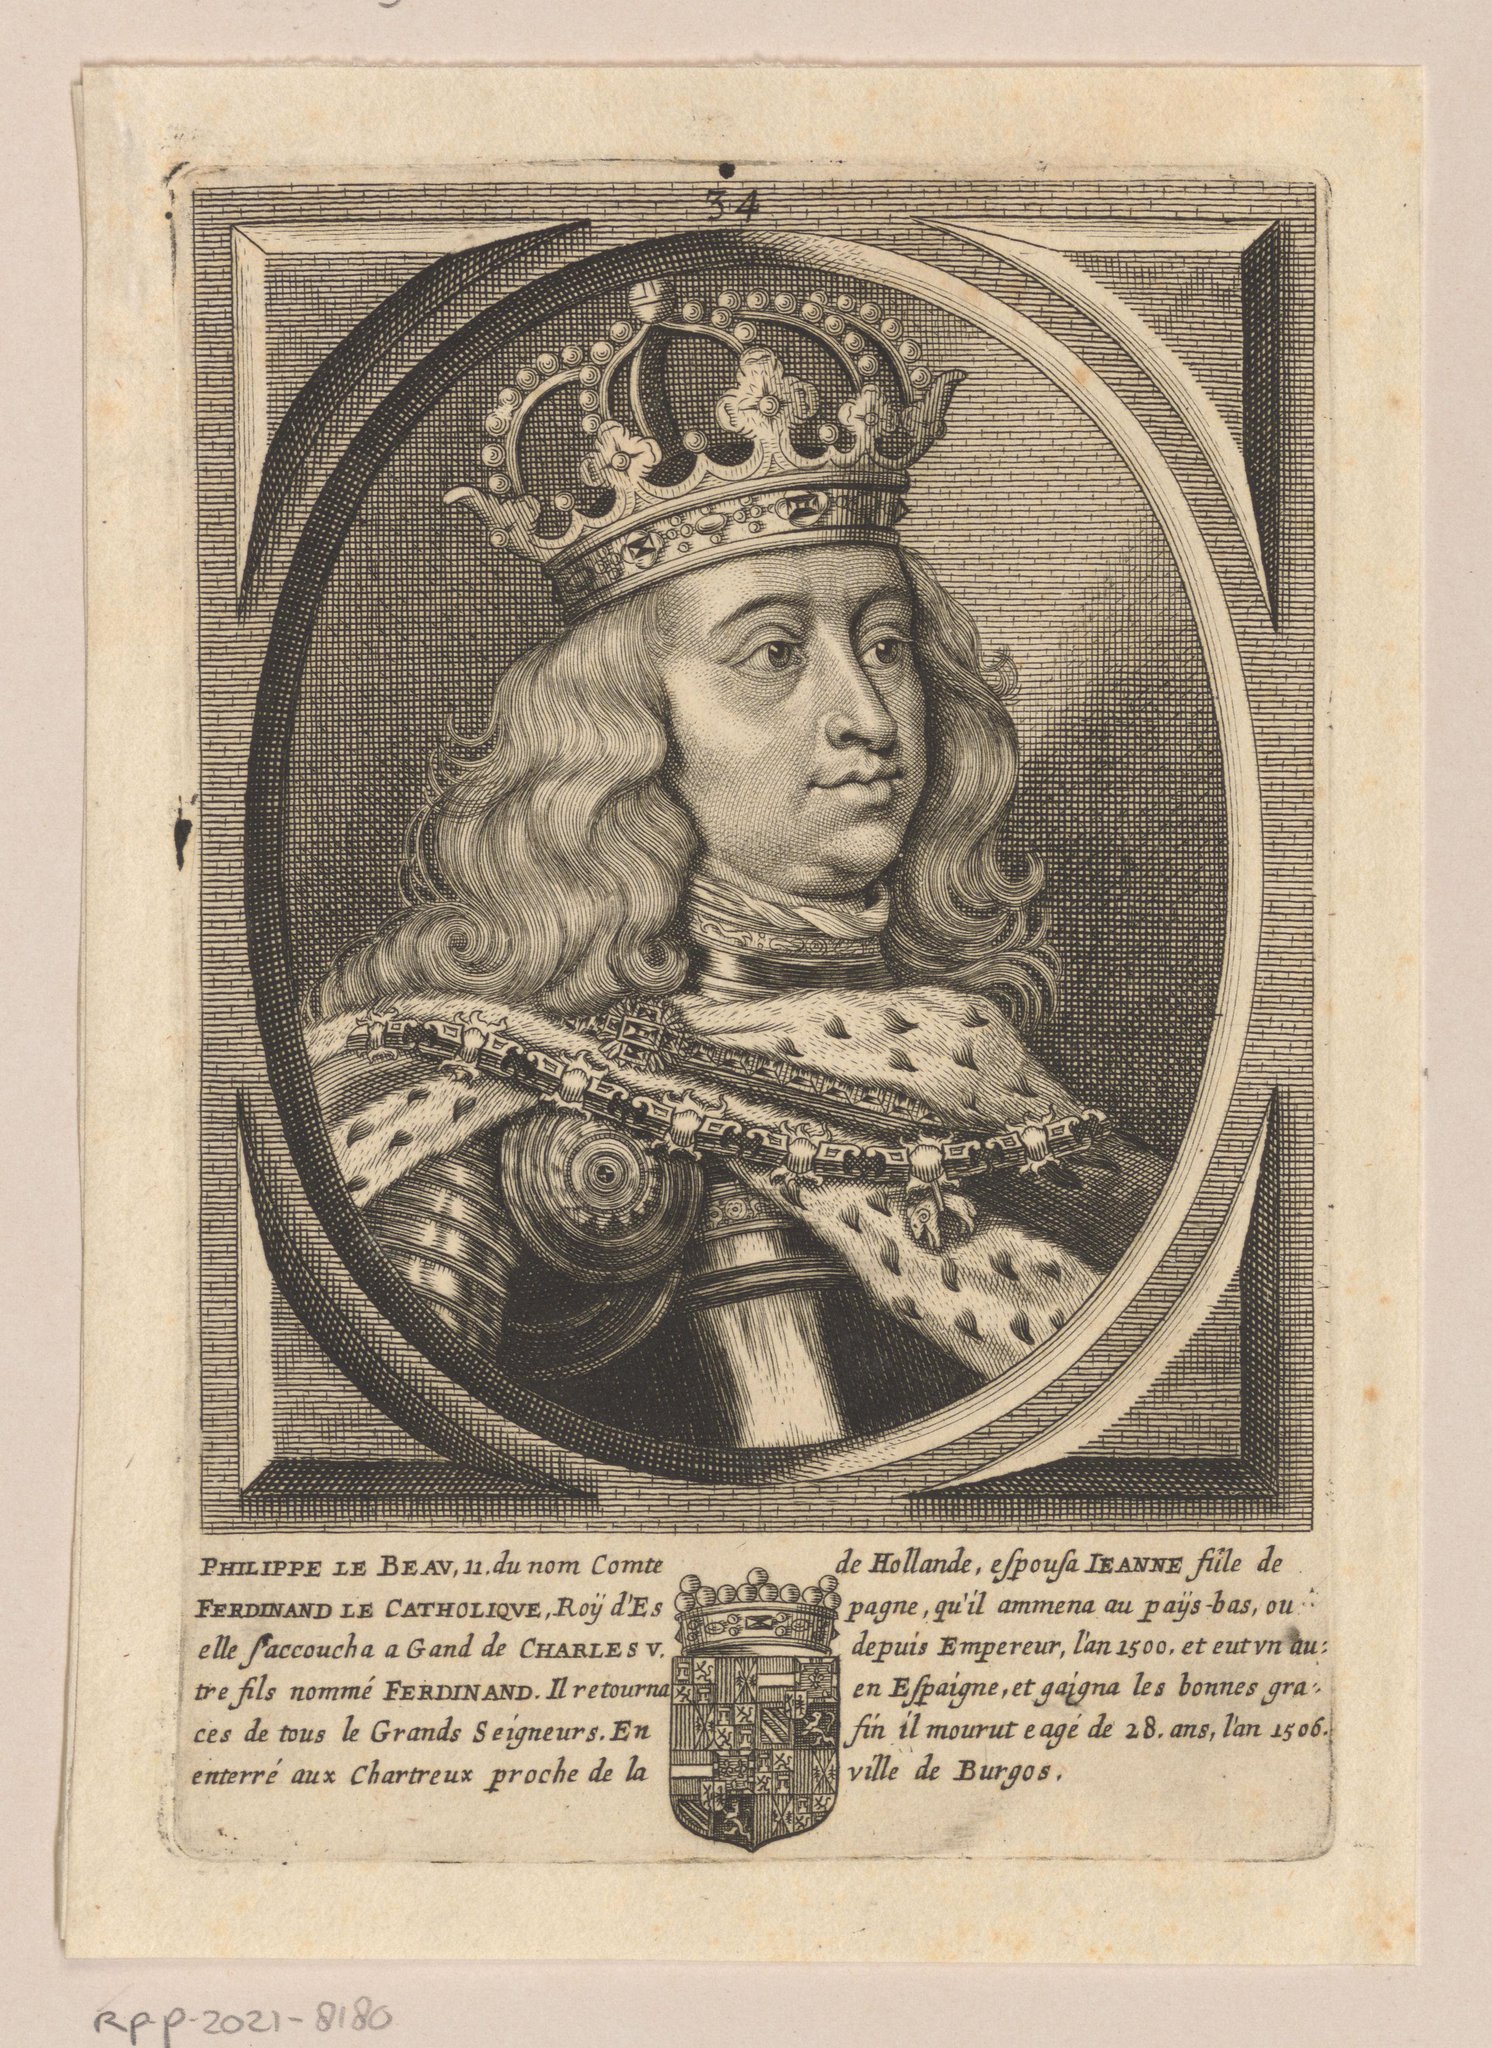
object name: print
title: Portret van Filips de Schone, hertog van Bourgondië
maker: Anonymous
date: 1600-1730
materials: paper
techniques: engraving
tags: bruges, filips de schone (hertog van bourgondië), crown (symbol of sovereignty), head-gear, historical persons, knighthood order of the golden fleece